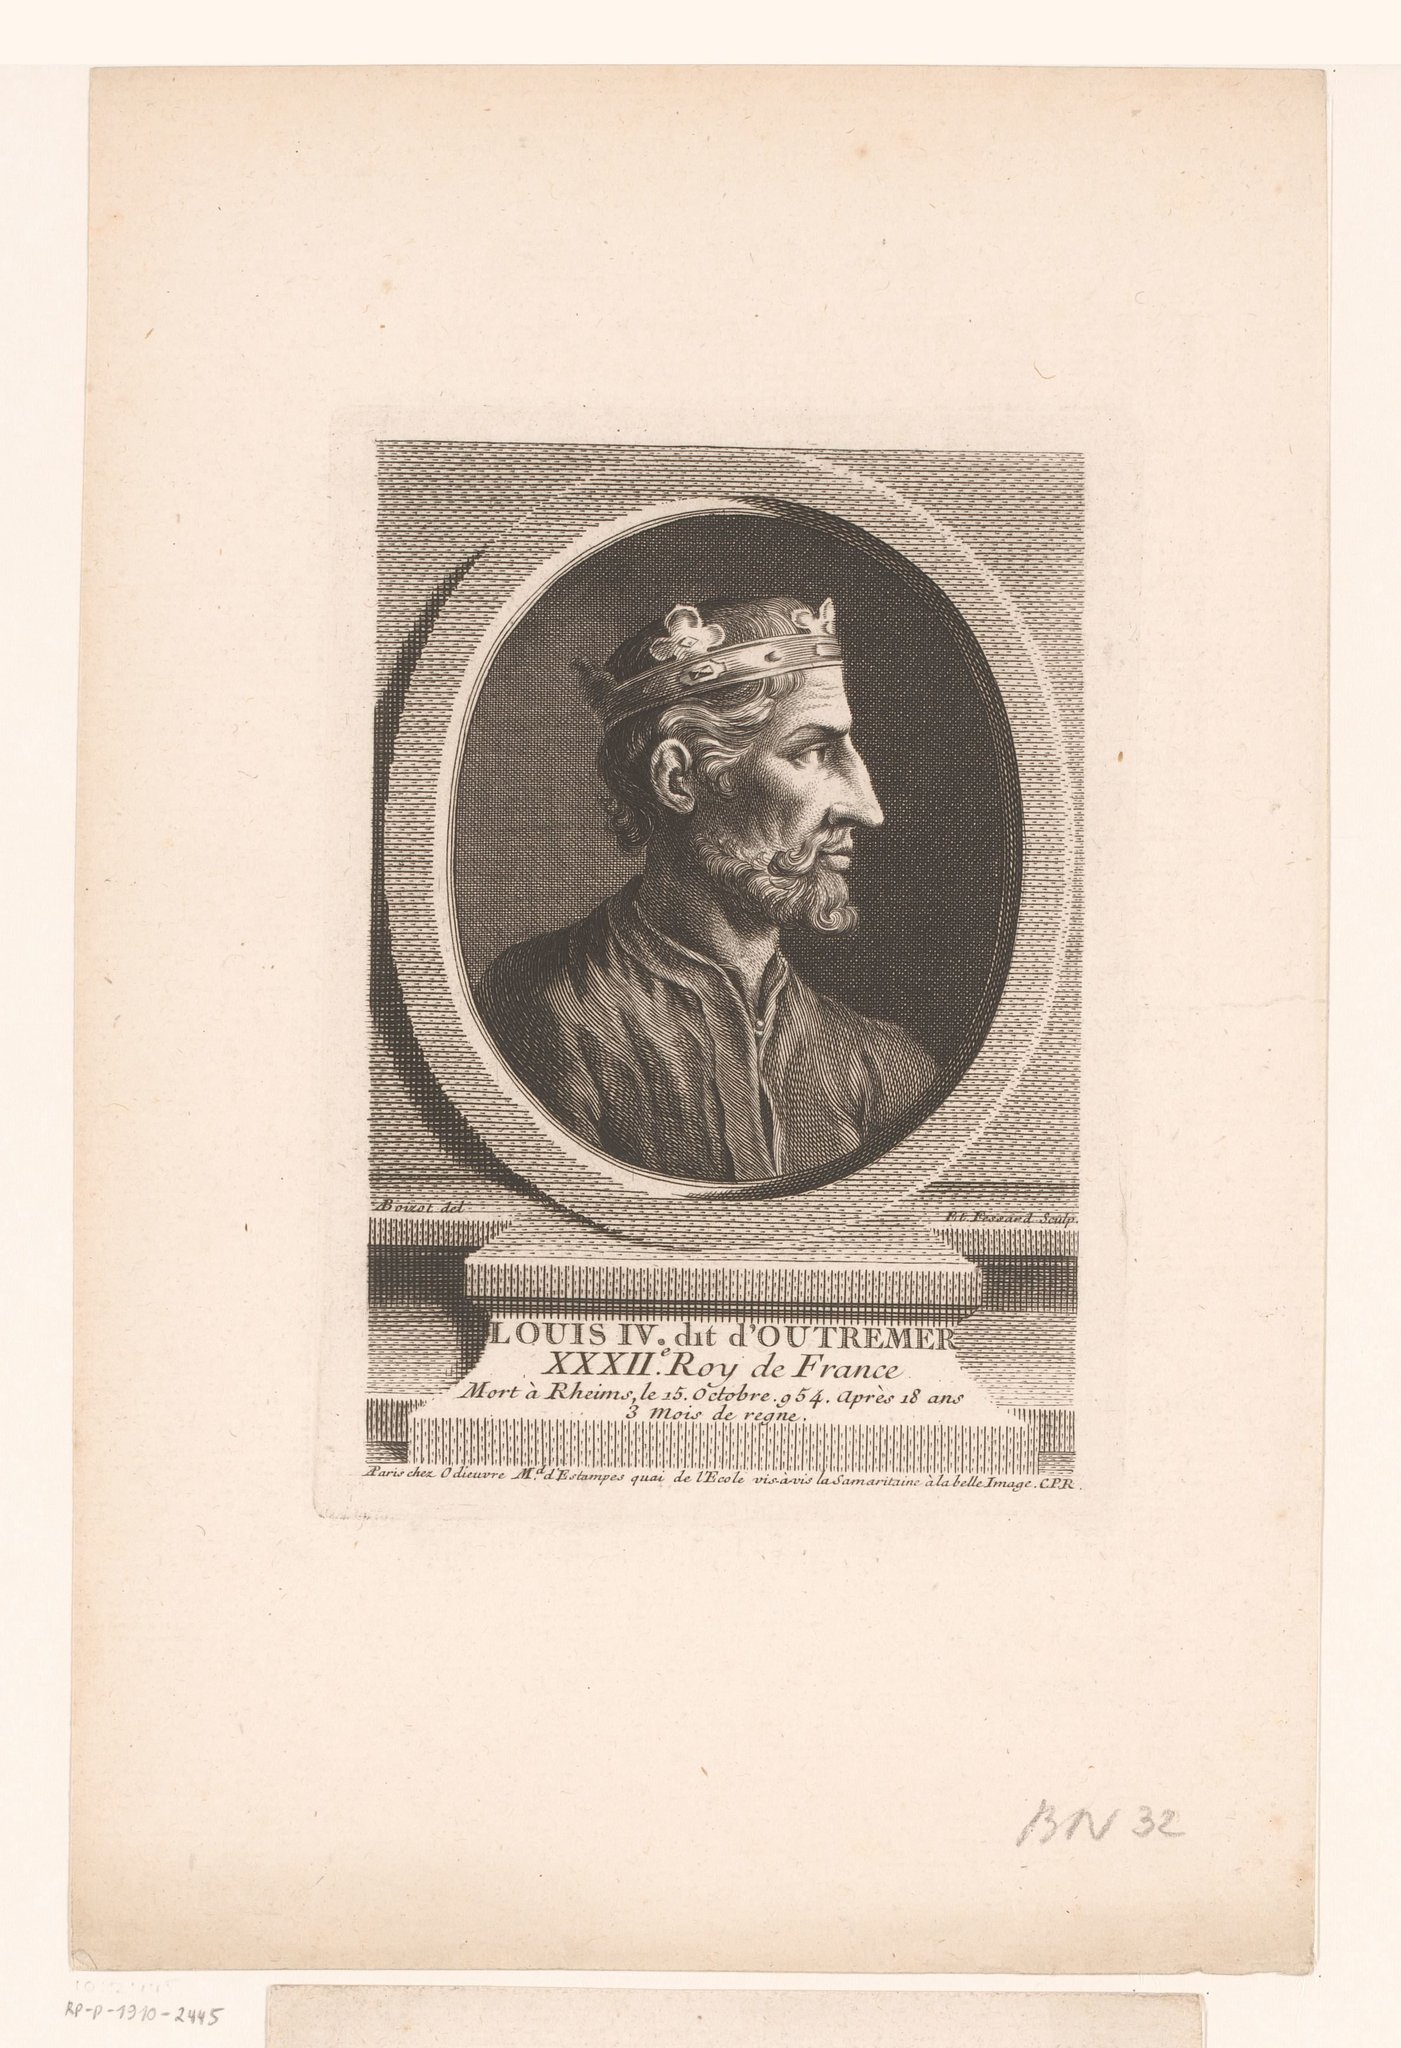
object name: print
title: Louis IV. dit d'Outremer XXXIIe. Roi de France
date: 1741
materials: paper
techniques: engraving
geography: paris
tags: ornament ~ medallion, historical persons, ruler, sovereign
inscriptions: collector's mark: Lugt 2228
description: Prent uit: Dreux du Radier, Jean-François. L'Europe illustré, contenant l'histoire abregée des souverains, des princes, des prélats, des ministres, (...) en Europe: dans le XVe. siècle compris, jusqu'à présent. Parijs: Michel Odieuvre en Jean-Luc Nyon, 1755, dl. 1.